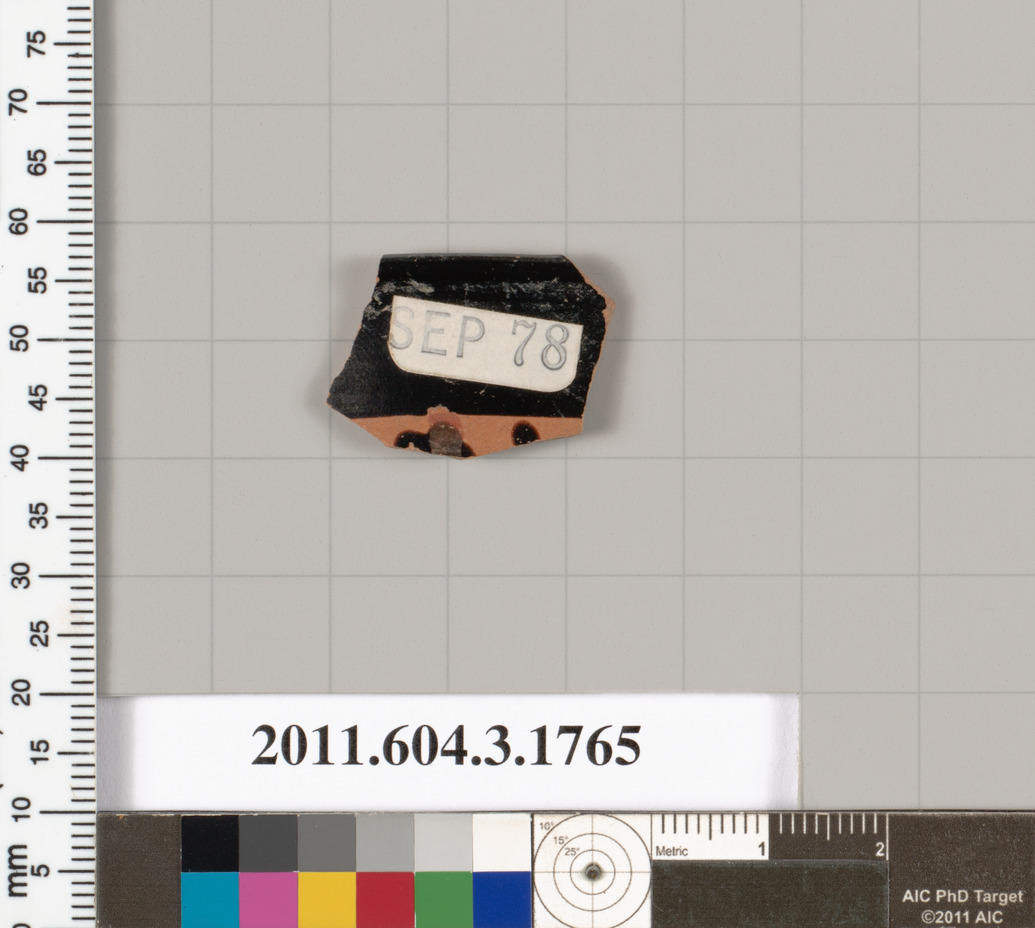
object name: kylix fragment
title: Terracotta rim fragment of a kylix: Band cup (drinking cup)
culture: greek, attic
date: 550-526 BCE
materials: terracotta